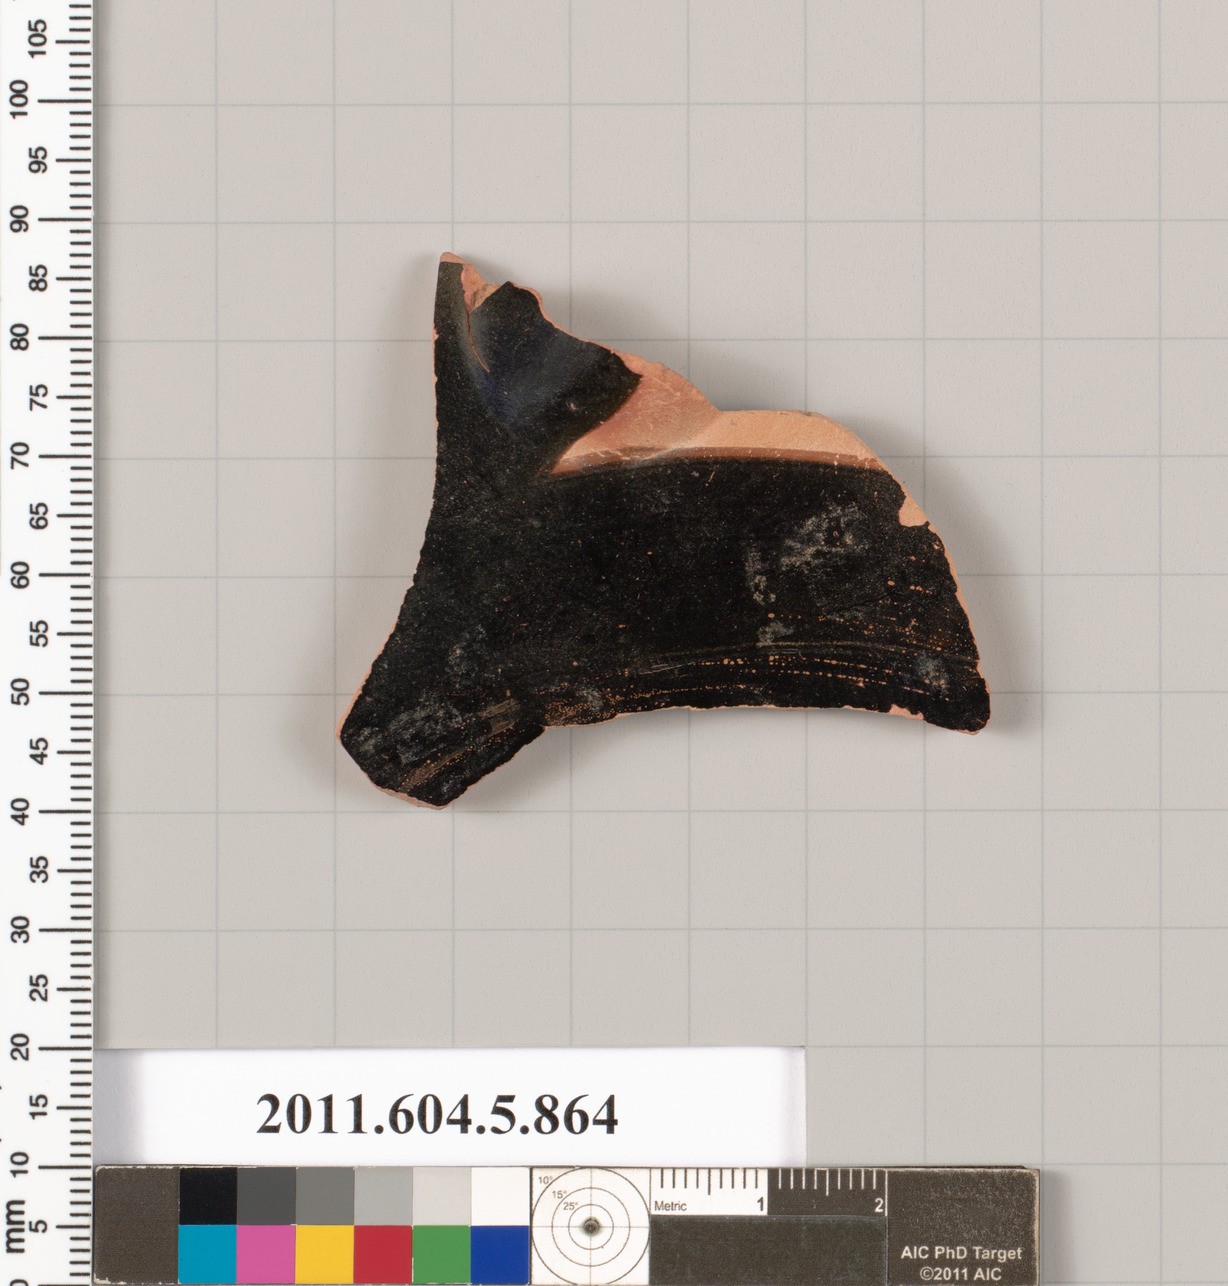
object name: kylix fragment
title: Terracotta fragment of a kylix (drinking cup)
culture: greek, attic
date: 600-401 BCE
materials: terracotta